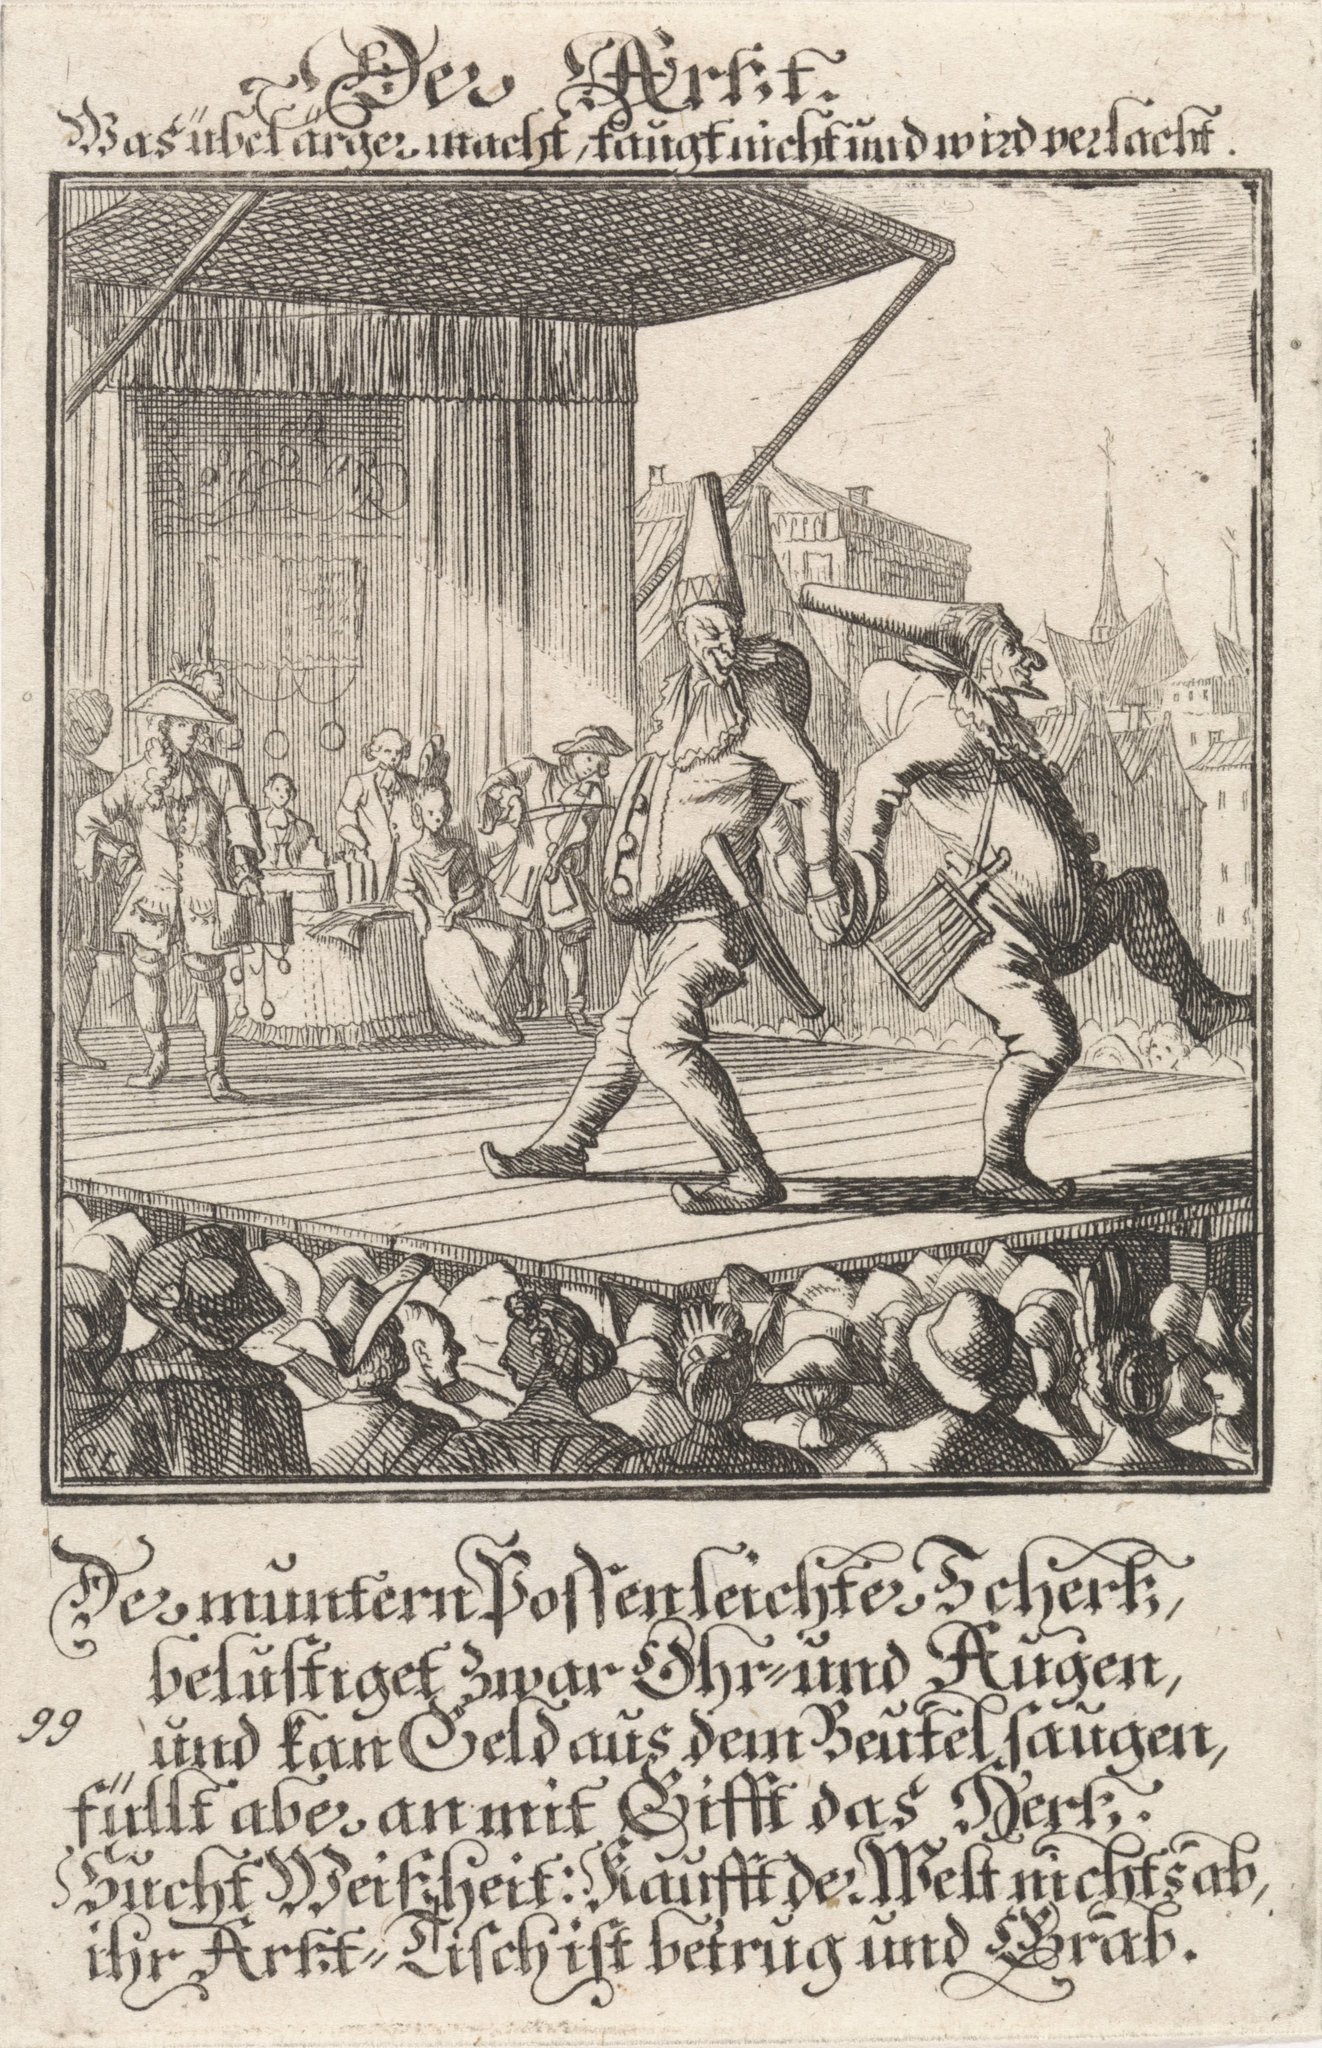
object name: print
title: Der Artzt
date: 1711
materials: paper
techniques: etching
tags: quack, charlatan, mountebank, 'saltimbanco'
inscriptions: collector's mark: Lugt 2228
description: Illustratie uit: Sancta Clara, Abraham à. Etwas für Alle, das ist: Eine kurtze Beschreibung allerley Stands- Ambts- und Gewerbs-Persohnen (...), 3 delen (1699-1733). Würtzburg: Martin Frantz Hertz, 1711, dl. III, p. 926. Het betreft hier de tweede druk van deel III.